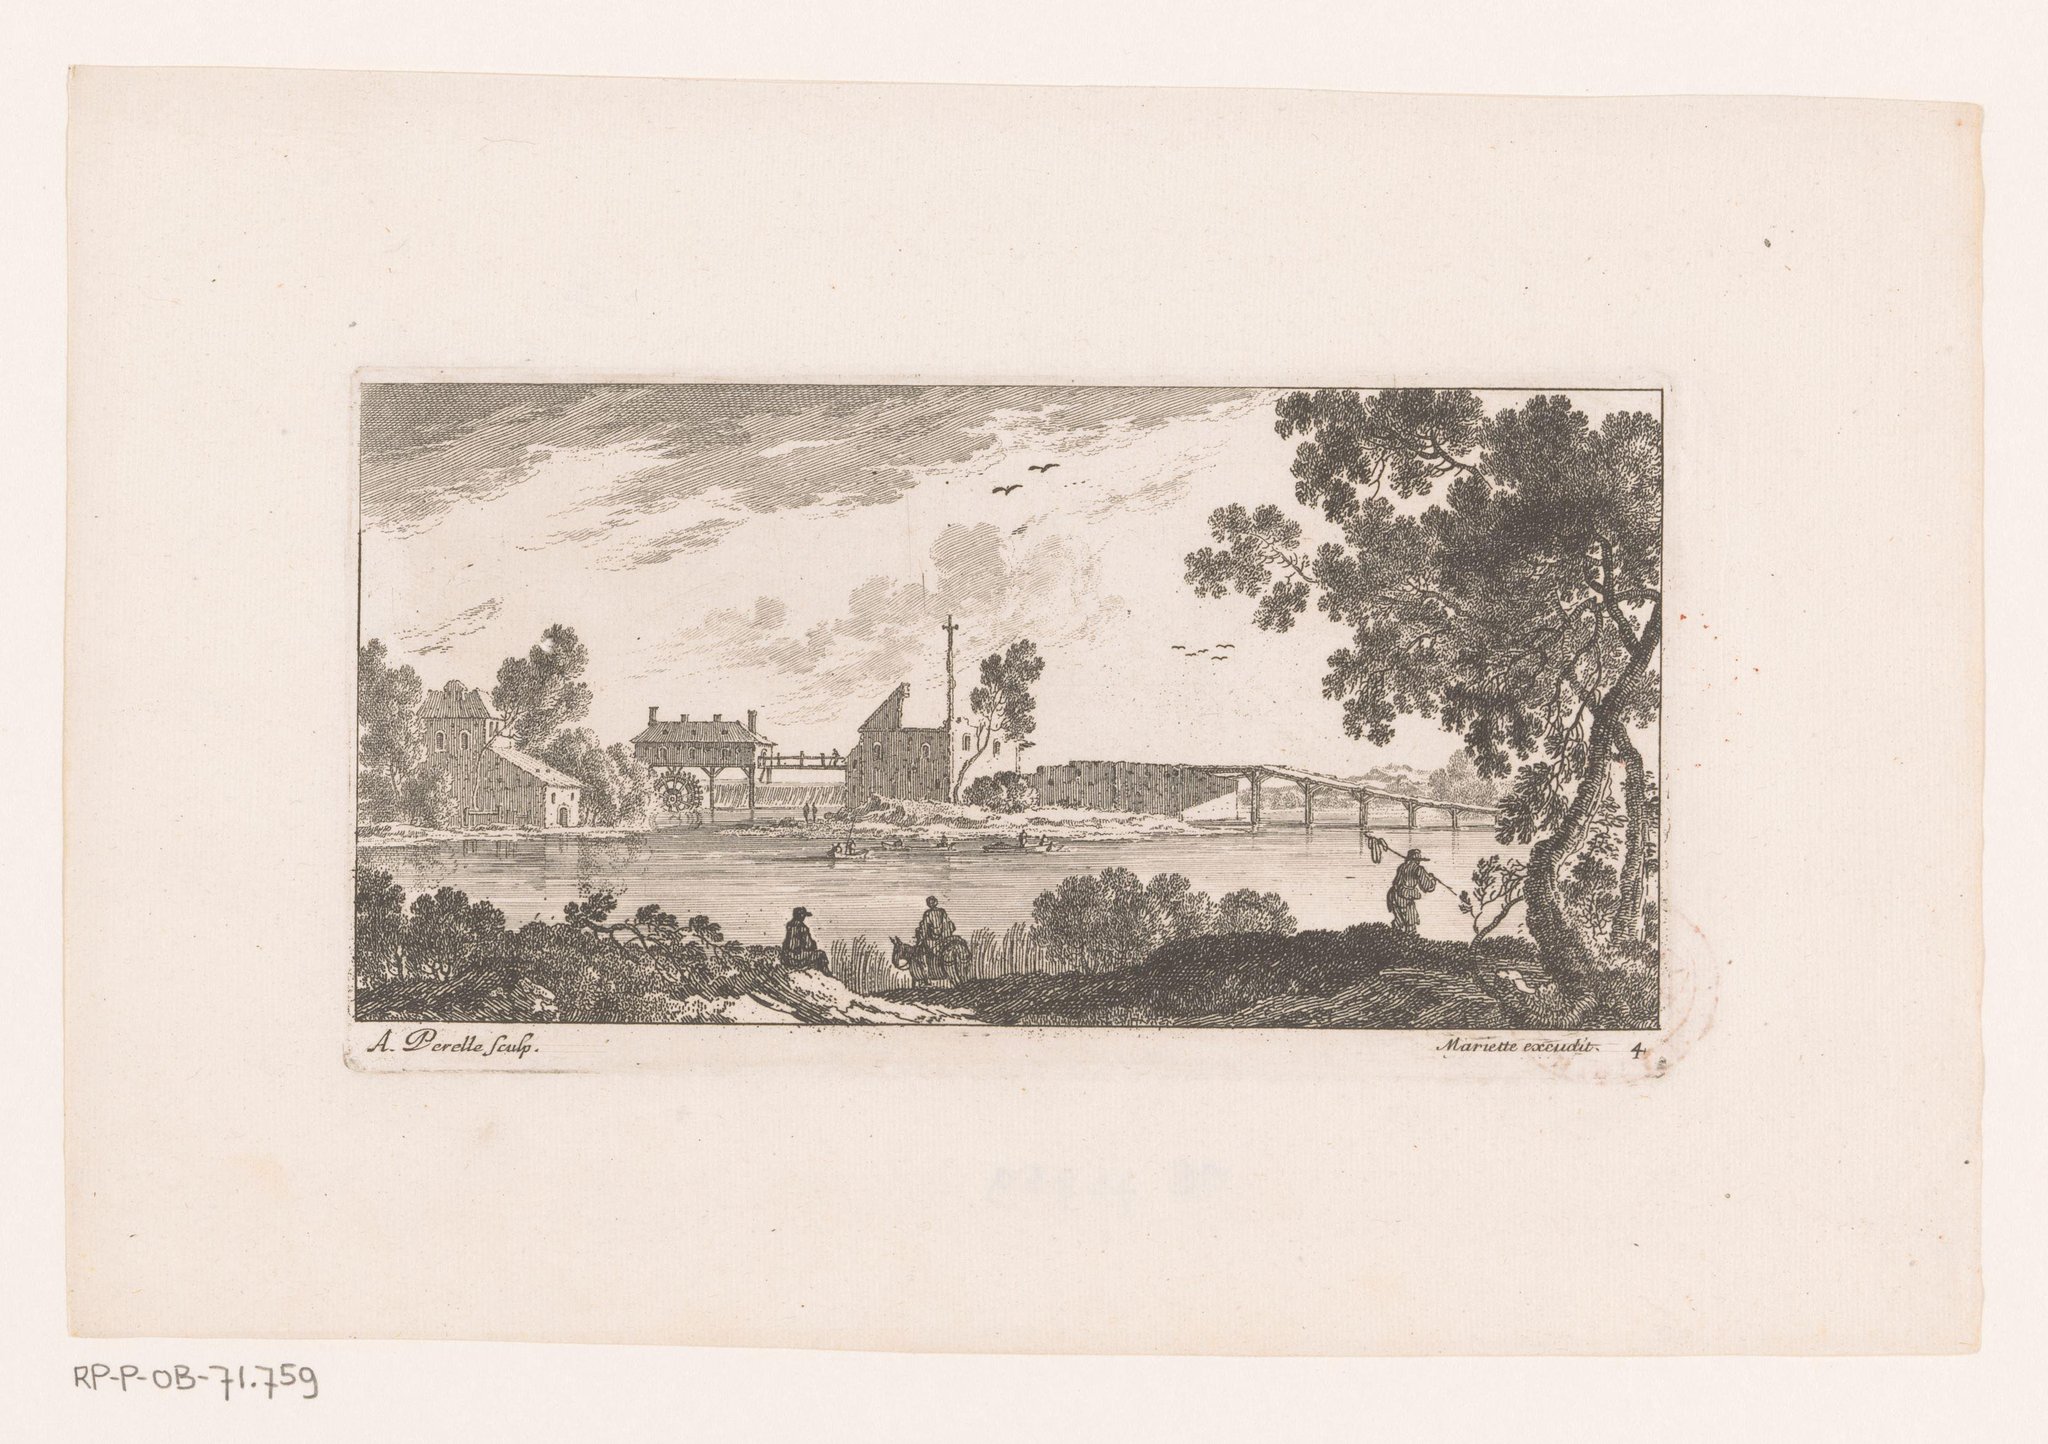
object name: print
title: Livre des diverses Paisages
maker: adam perelle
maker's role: draughtsman, print maker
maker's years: 1638-1695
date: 1650-1695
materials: paper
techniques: etching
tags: watermill in landscape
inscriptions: collector's mark: Lugt 240